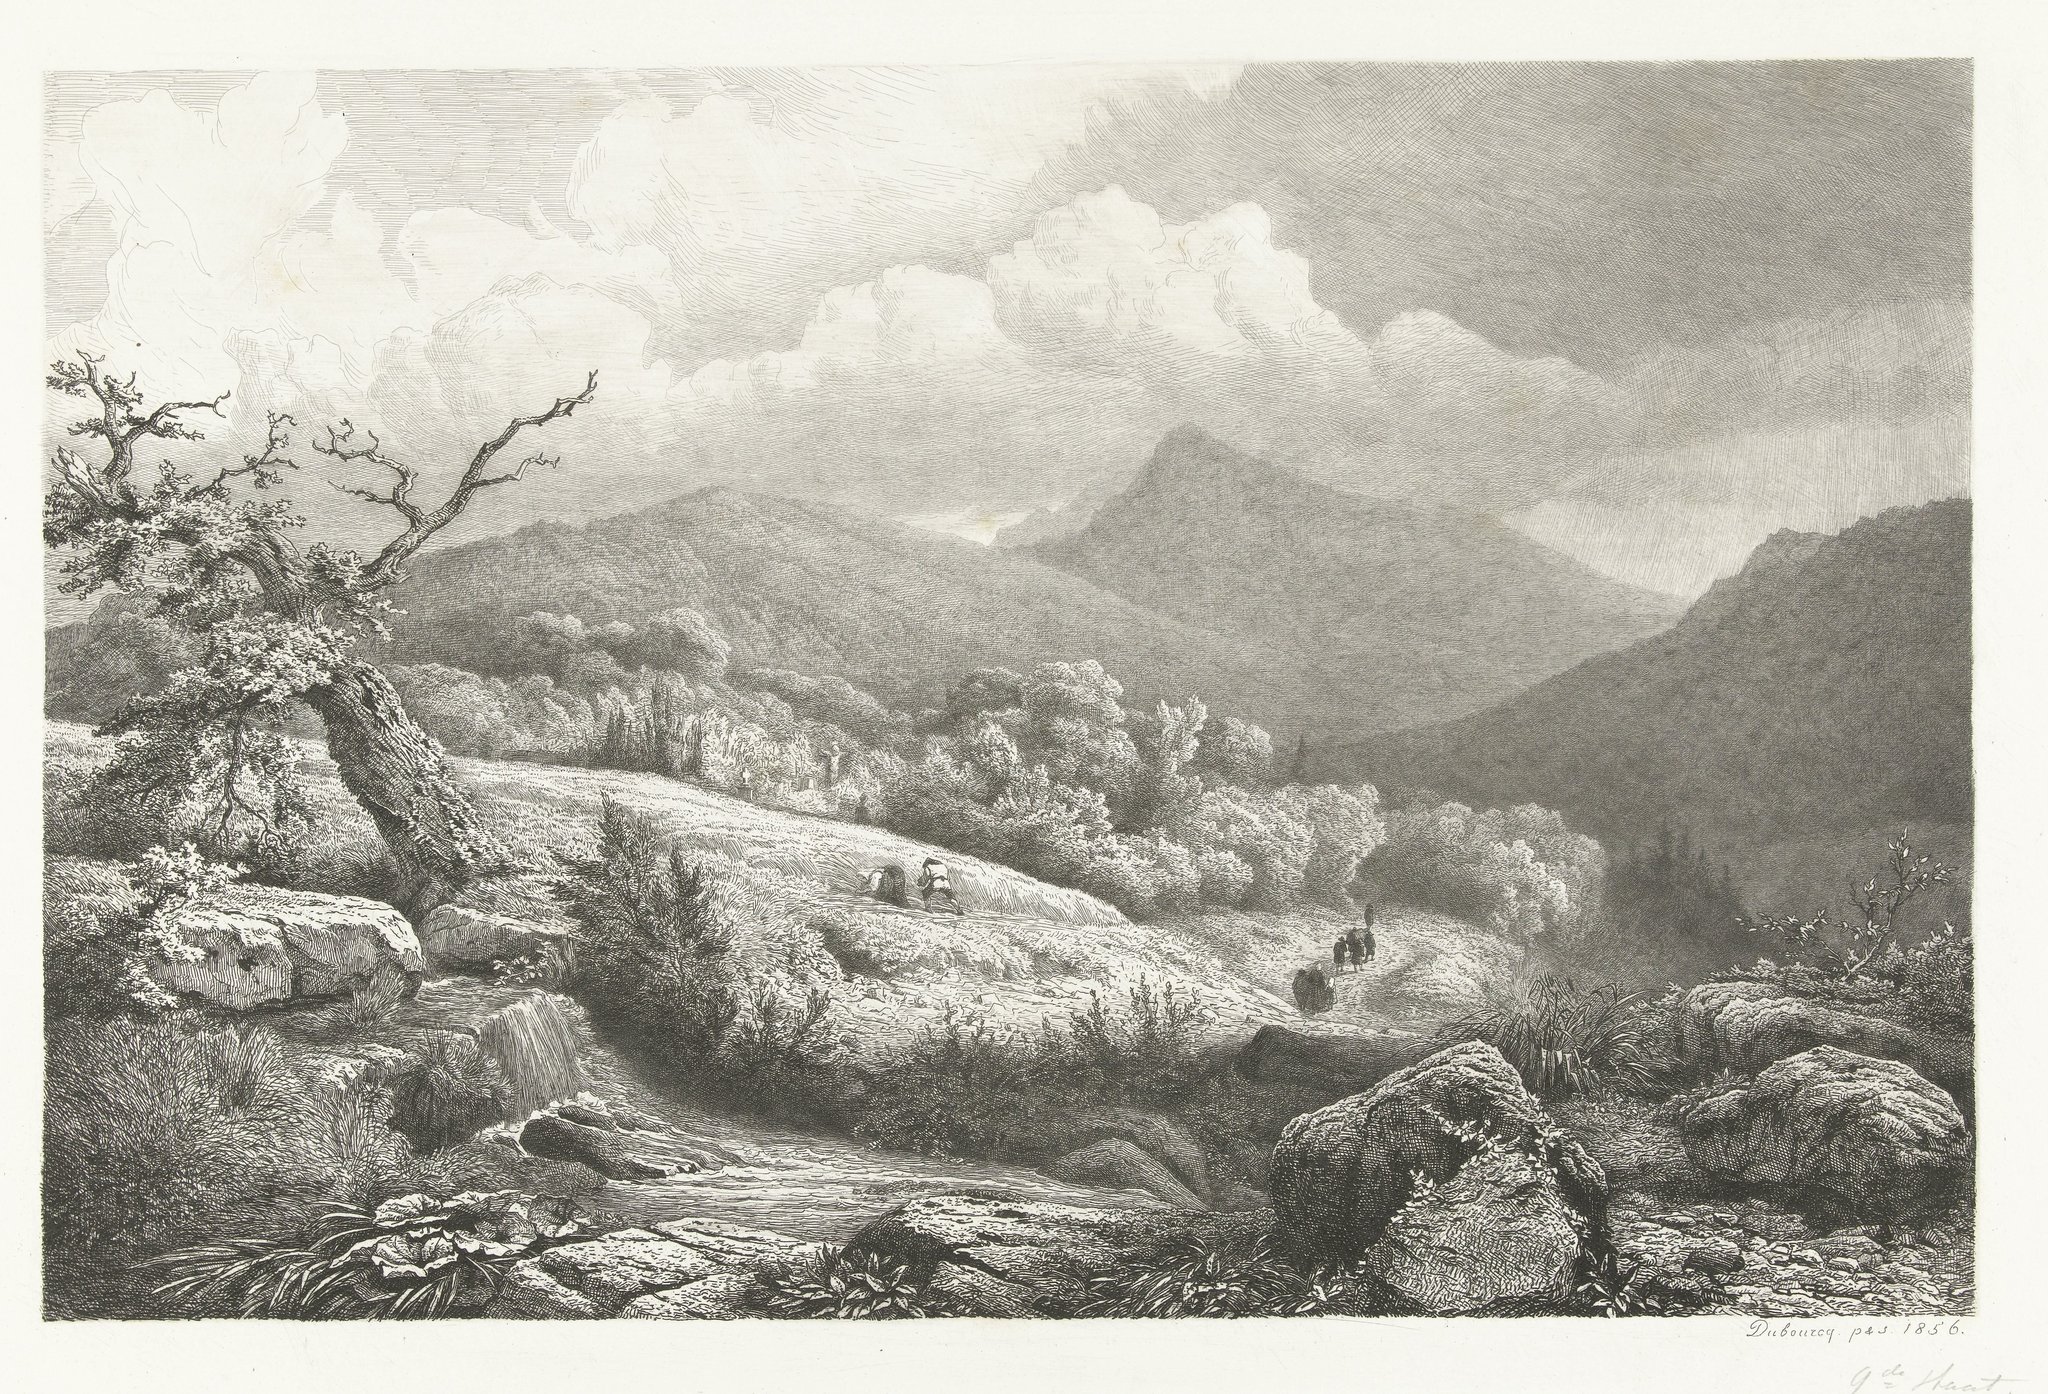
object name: print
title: De begraafplaats te Baden-Baden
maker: pierre louis dubourcq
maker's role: draughtsman, painter, print maker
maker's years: 1815-1873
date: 1856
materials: paper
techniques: etching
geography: netherlands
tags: landscape with other man-made constructions not mentioned above, e.g.: graveyards, playgrounds, etc.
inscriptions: collector's mark: Lugt 2228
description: De begraafplaats te Baden-Baden. Berglandschap met een kleine begrafenisstoet op weg naar de begraafplaats links tussen de bomen. Op de voorgrond een watervalletje.